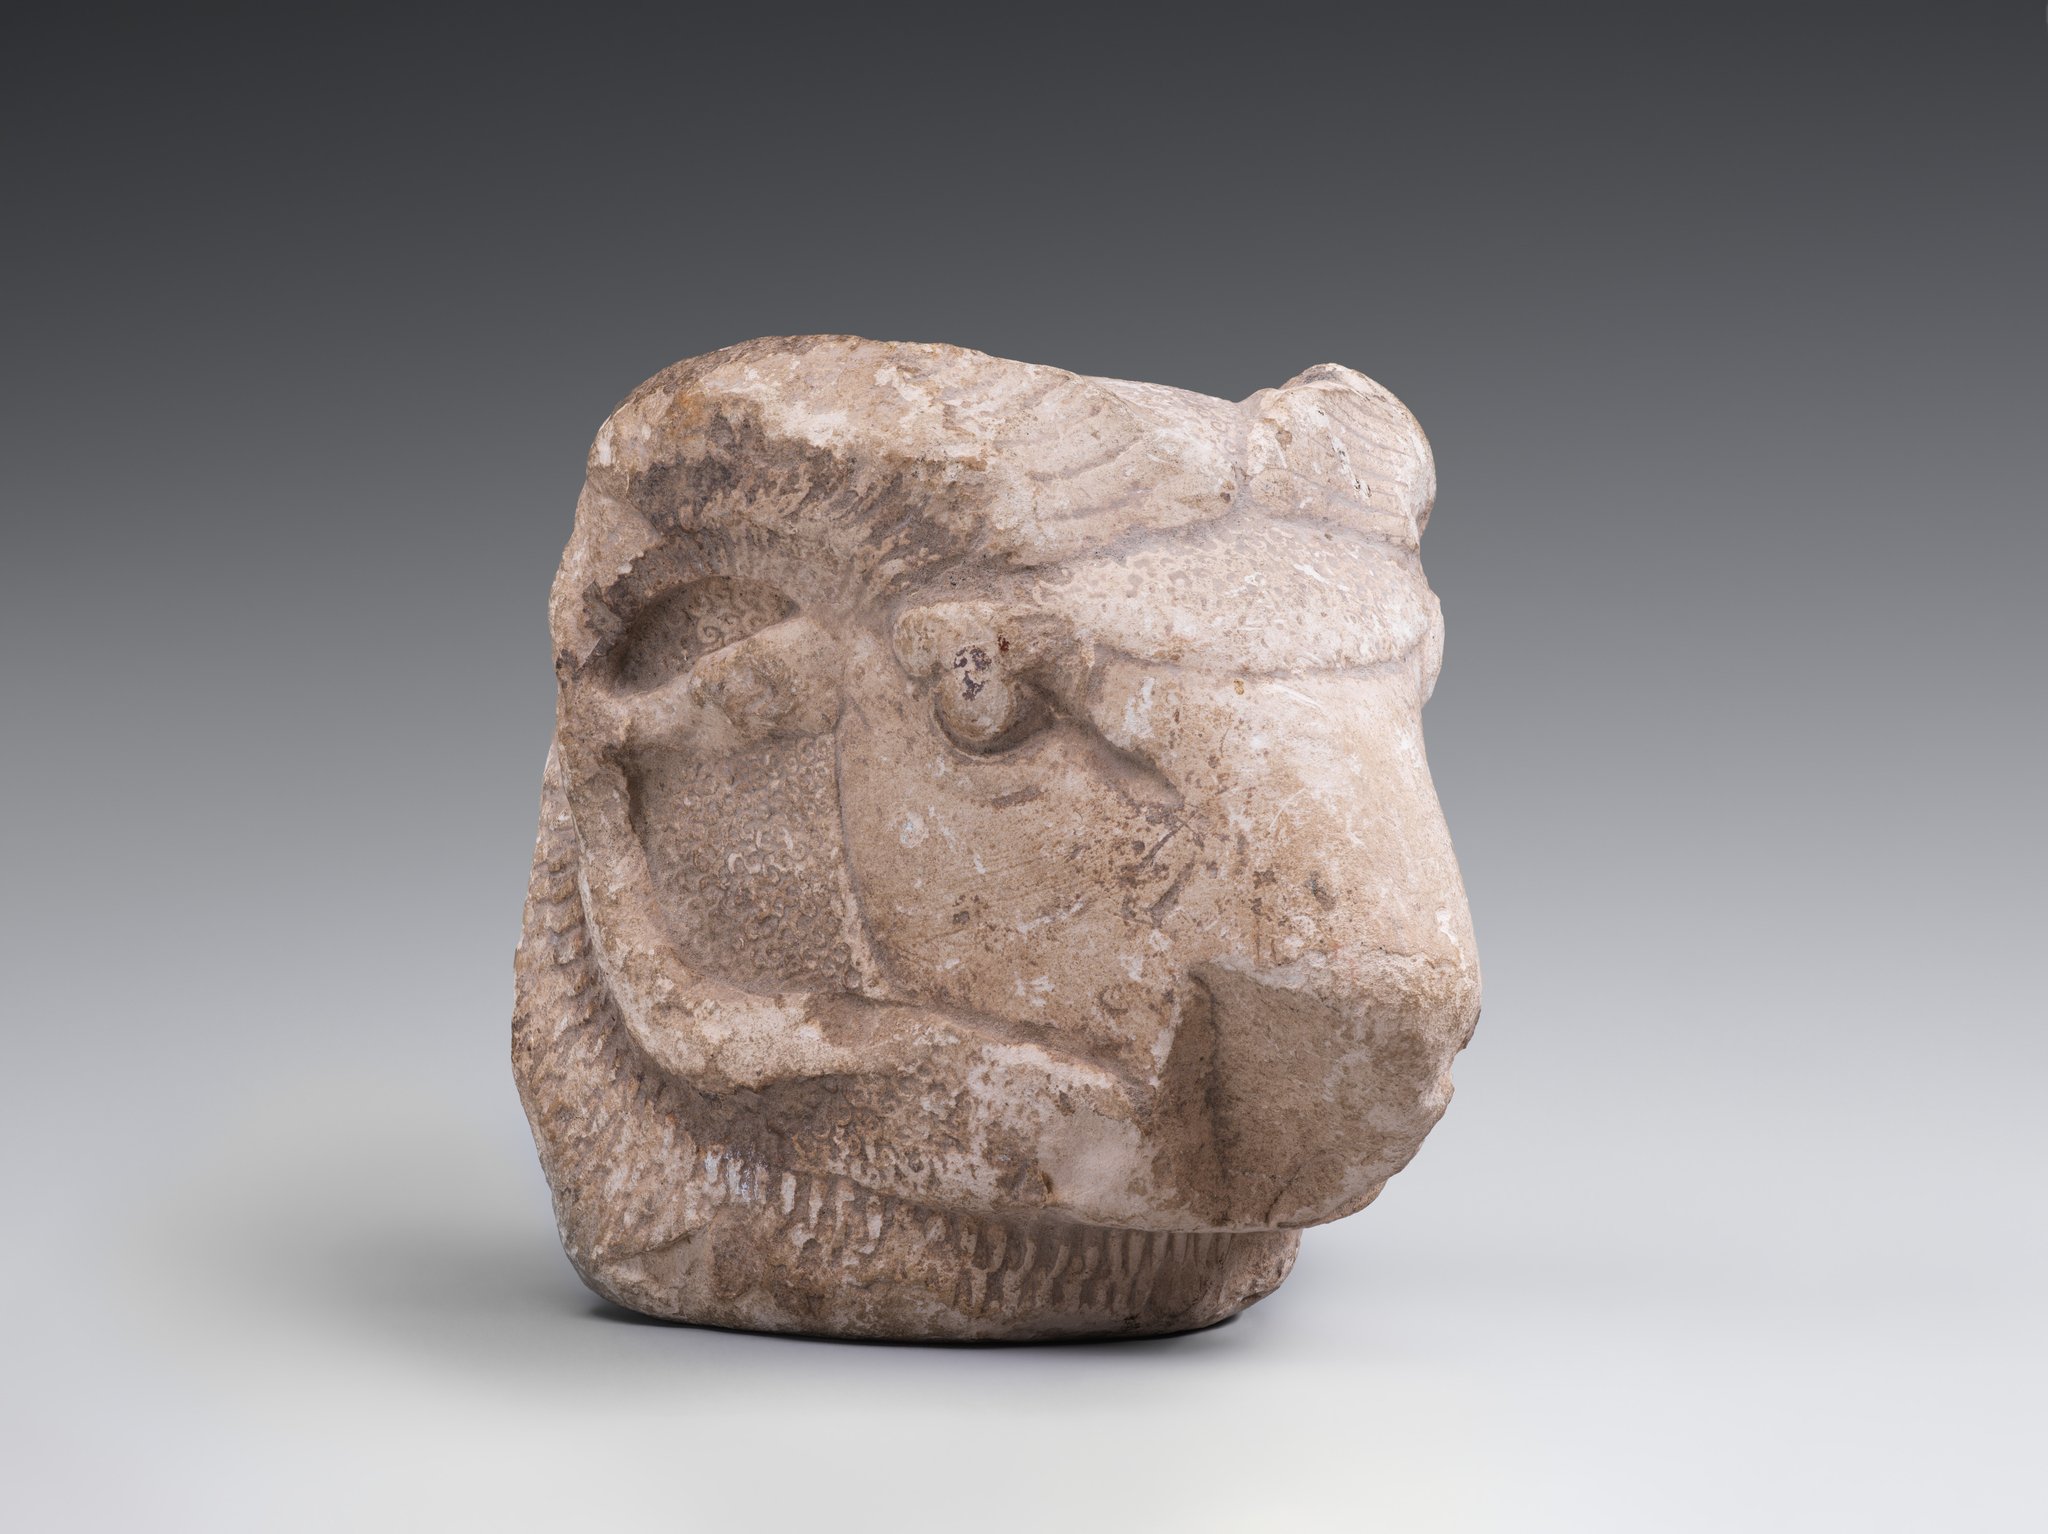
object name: sculpture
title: Head of a ram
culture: achaemenid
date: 500-301 BCE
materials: limestone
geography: egypt (?)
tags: rams